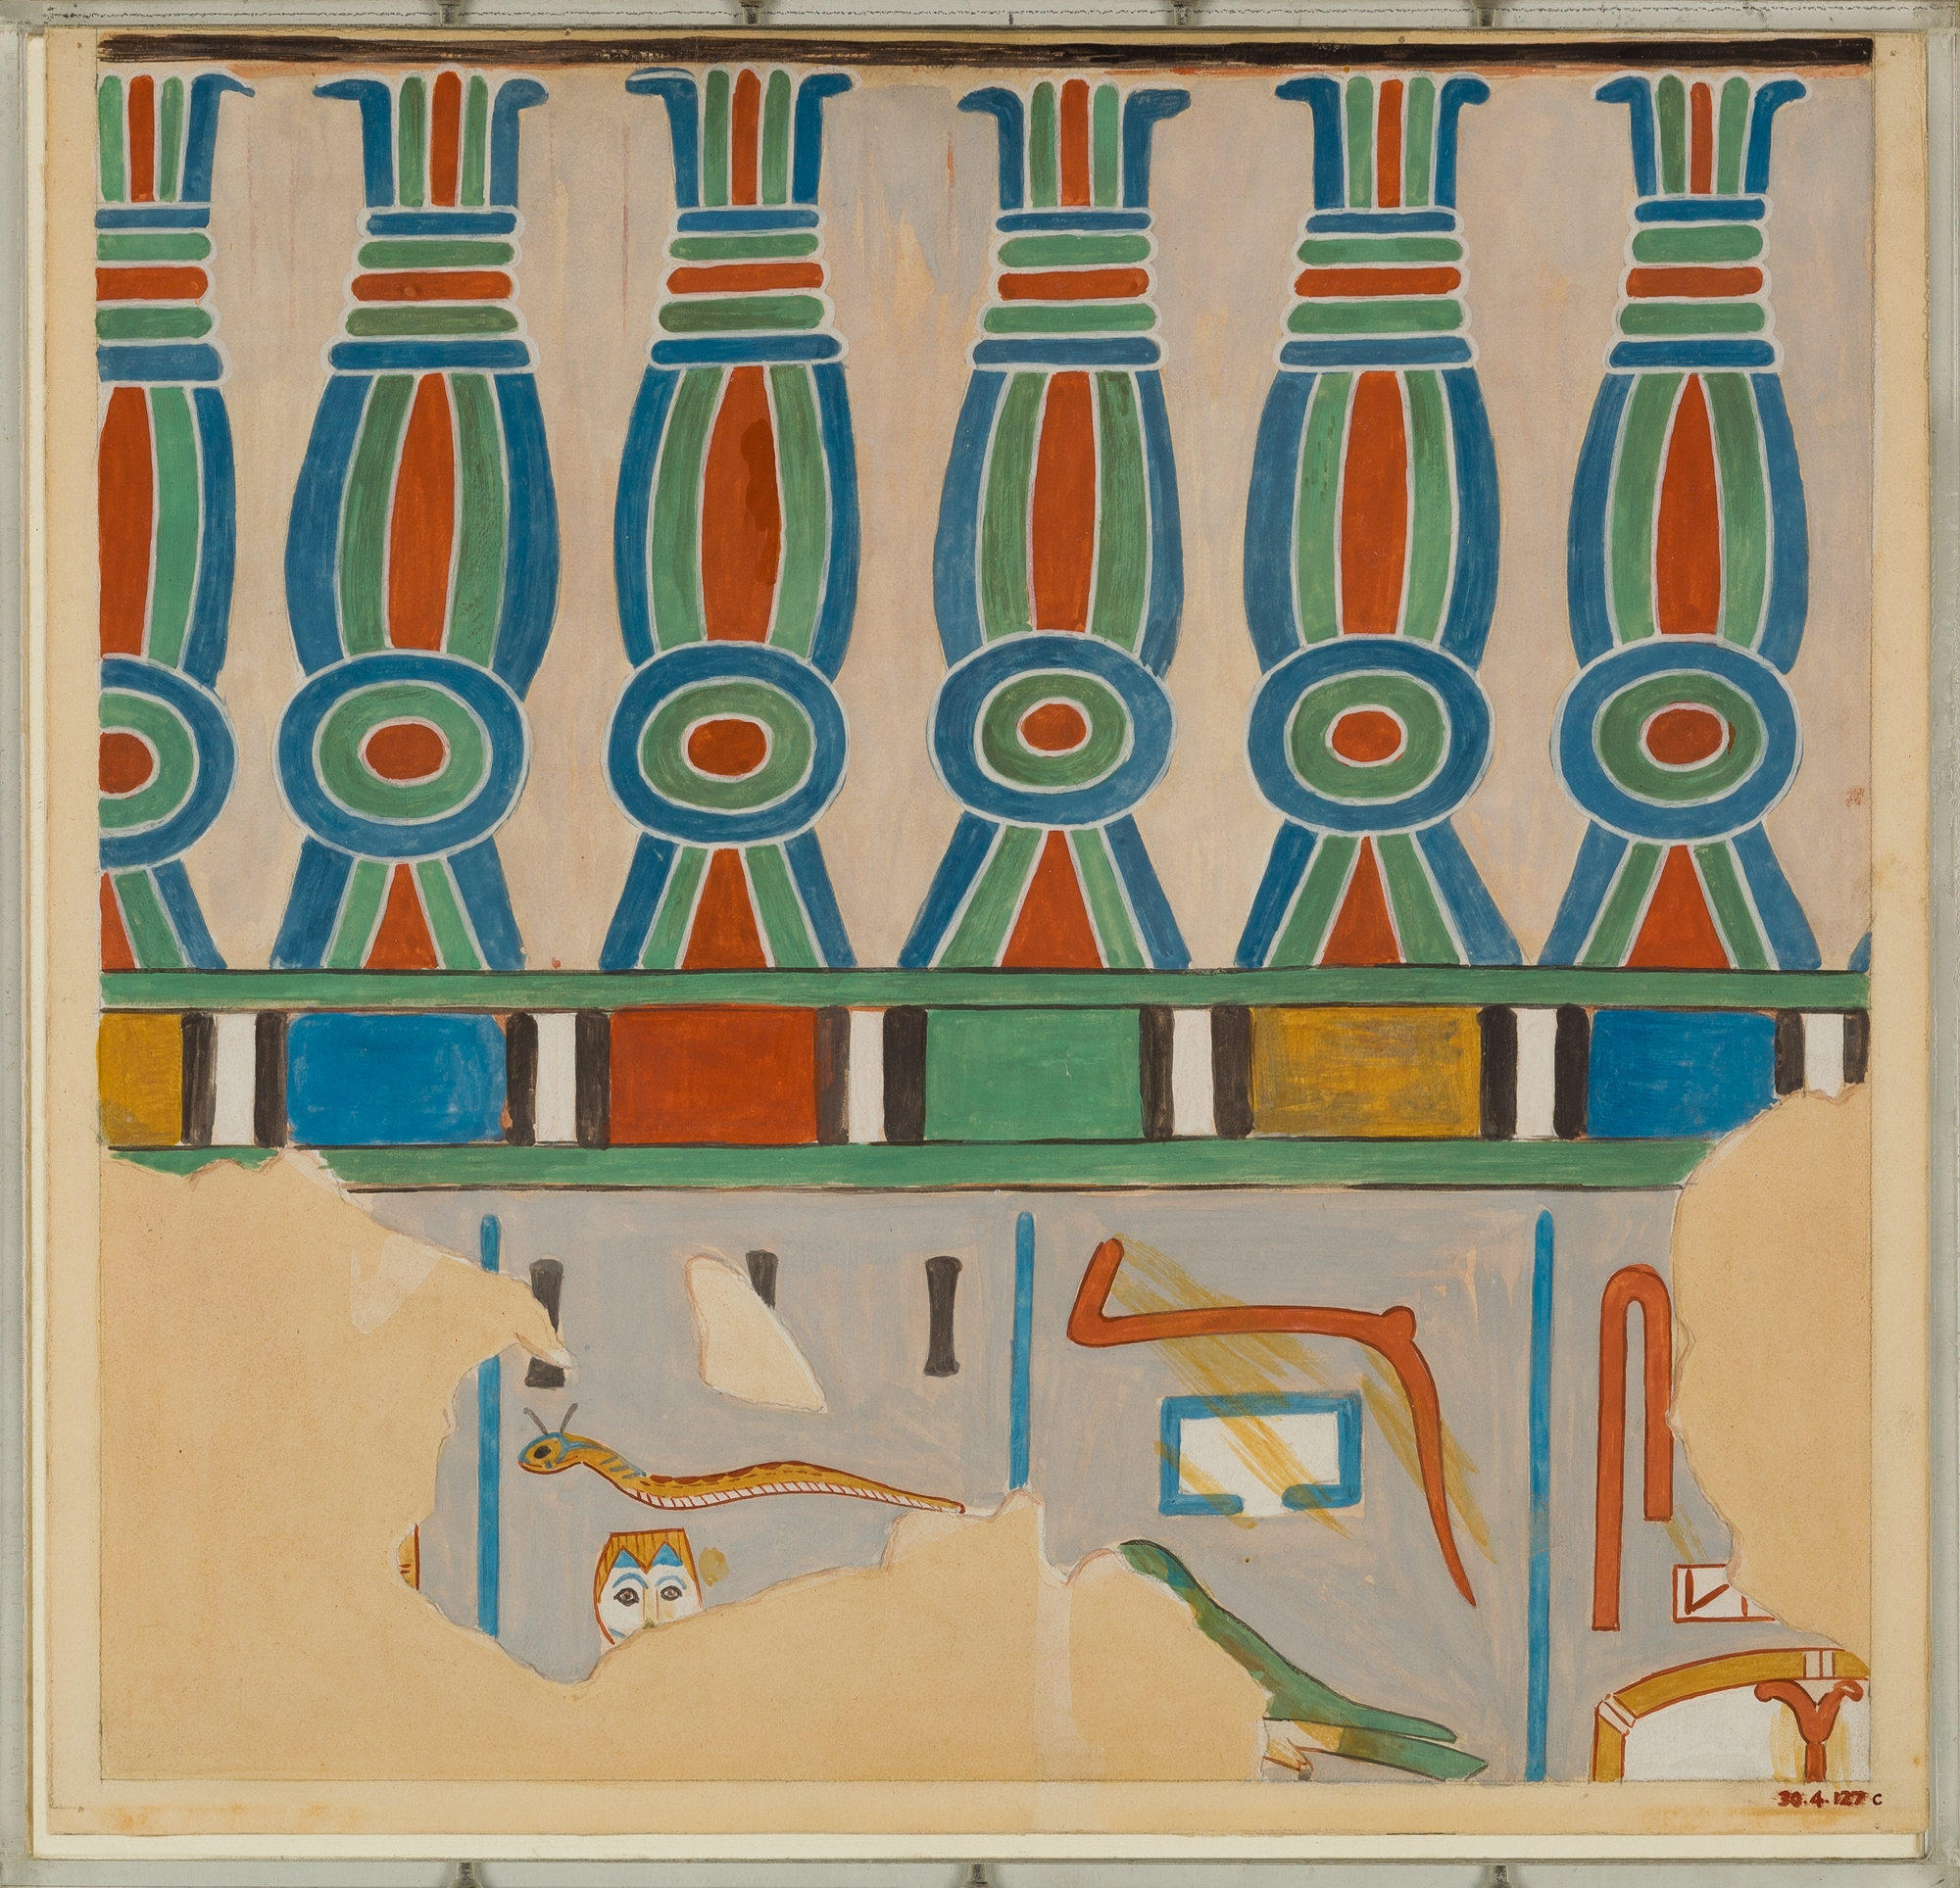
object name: facsimile, tjay tt 349, kheker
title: Kheker Friese, Tomb of Tjay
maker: charles k. wilkinson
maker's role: artist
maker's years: 1897-1986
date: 1550-1458 BCE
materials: paper, paint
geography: egypt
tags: hieroglyphs